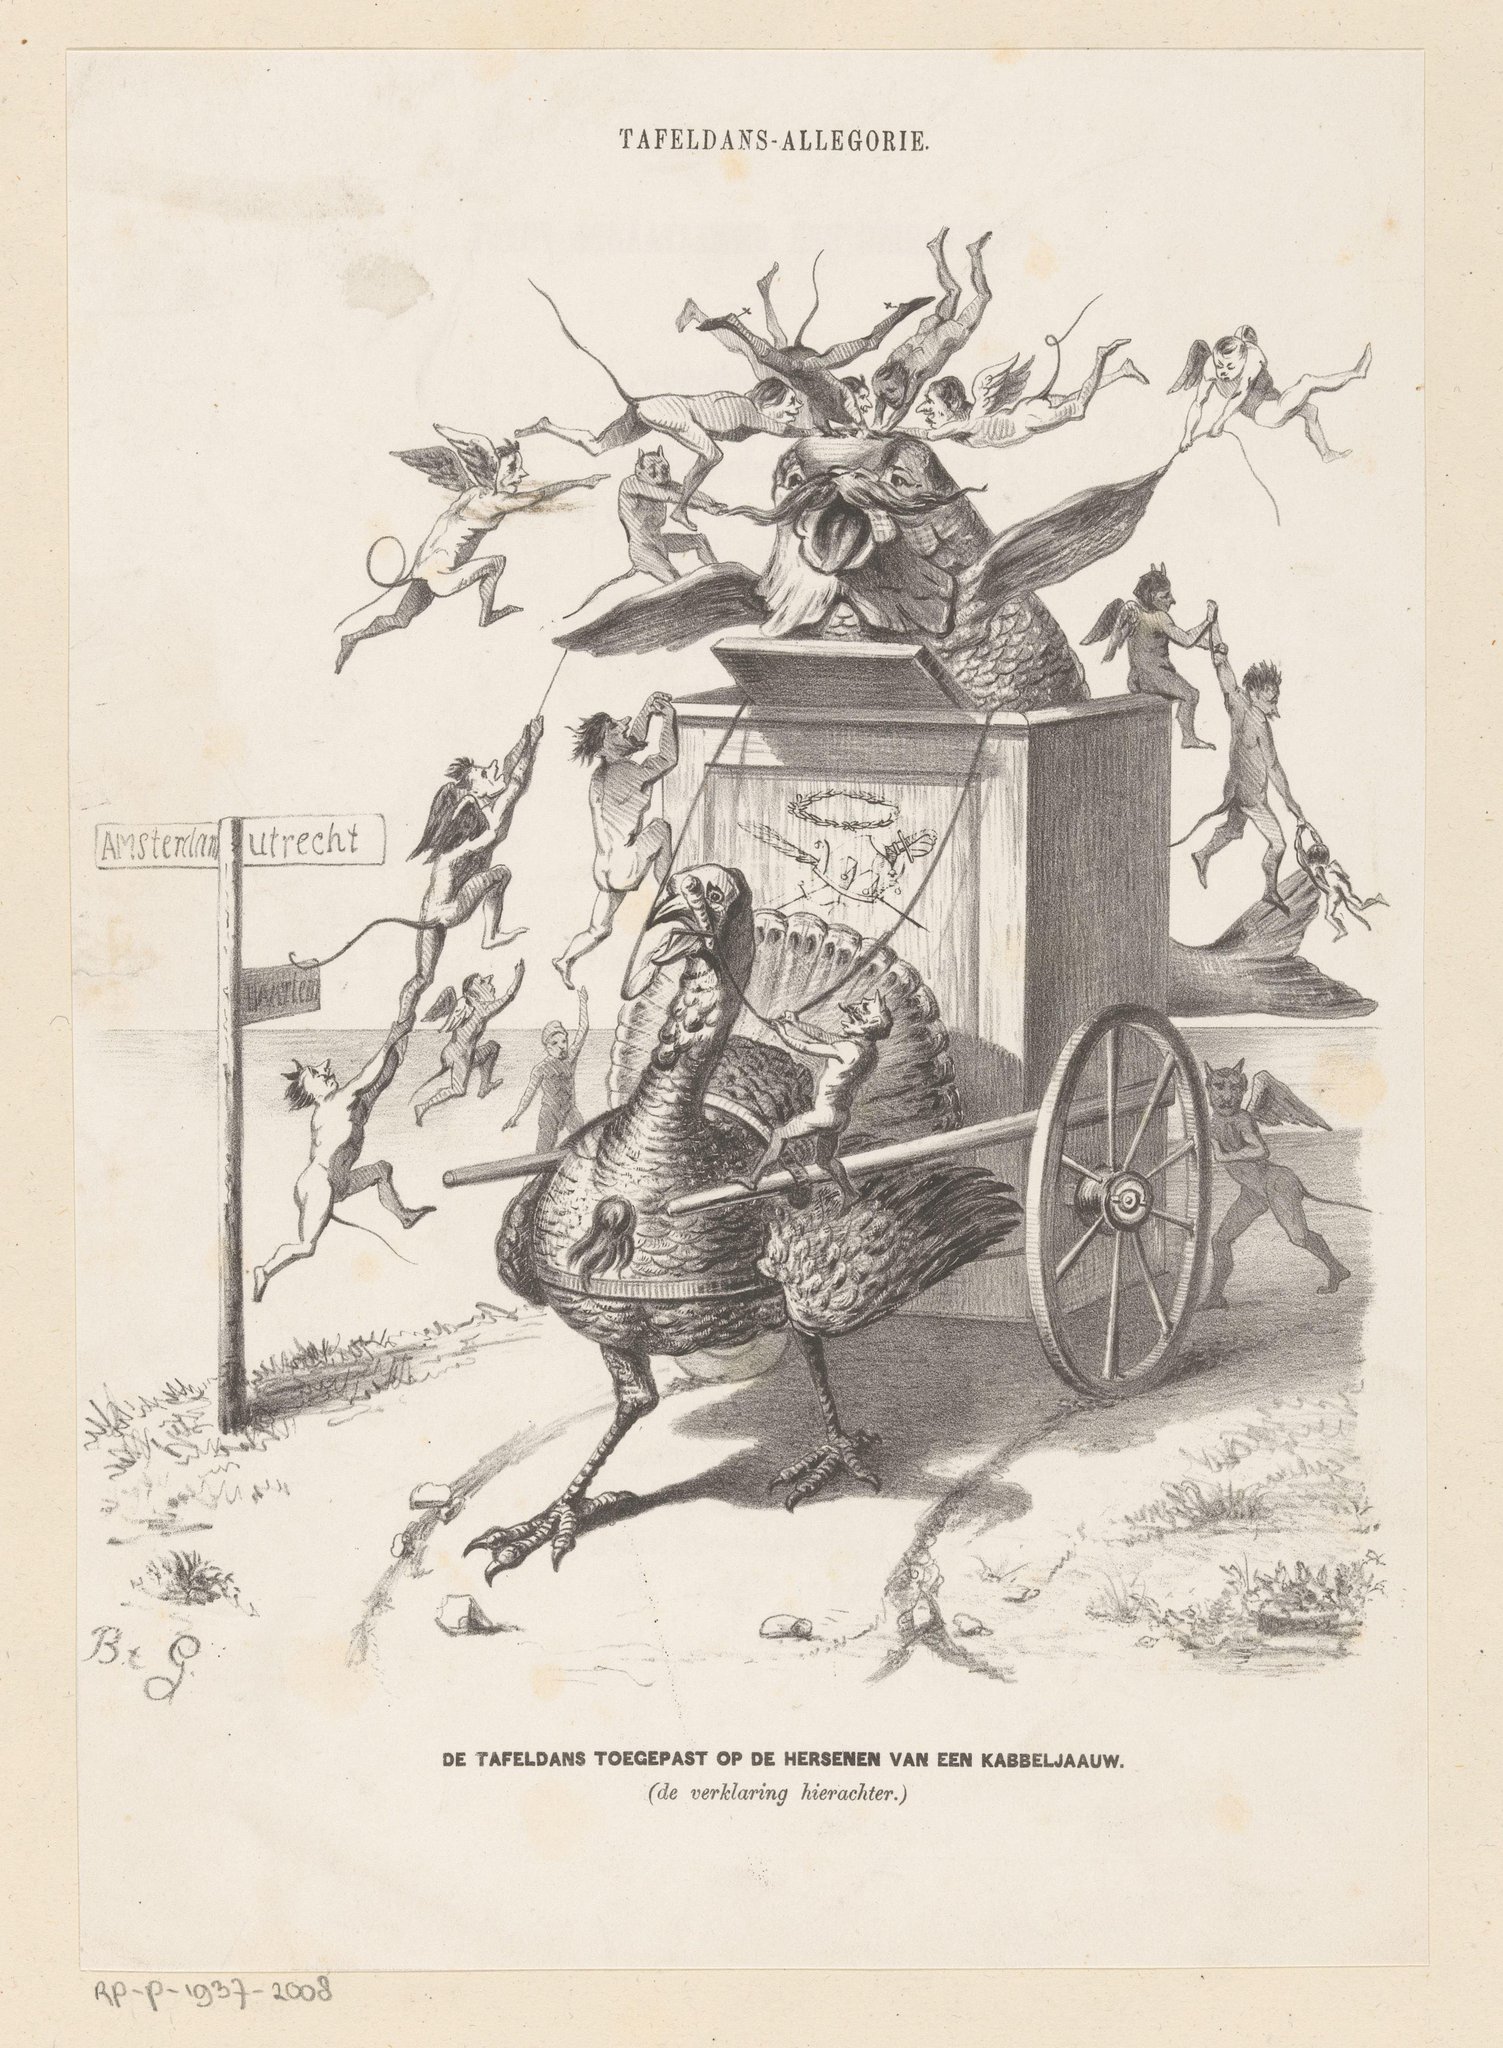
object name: print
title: Kabeljauw voorgetrokken door een kalkoen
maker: Anonymous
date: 1809-1899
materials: paper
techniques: lithograph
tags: bony fishes: cod, walker and runner birds: turkey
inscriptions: collector's mark: Lugt 2760, collector's mark: Lugt 2228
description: De kabeljauw in de wagen wordt aangevallendoor duivels. Links een wegwijzer met daarop Amsterdam, Utrecht en Haarlem. Op de achterkant van het blad staat een toelichting op de prent.